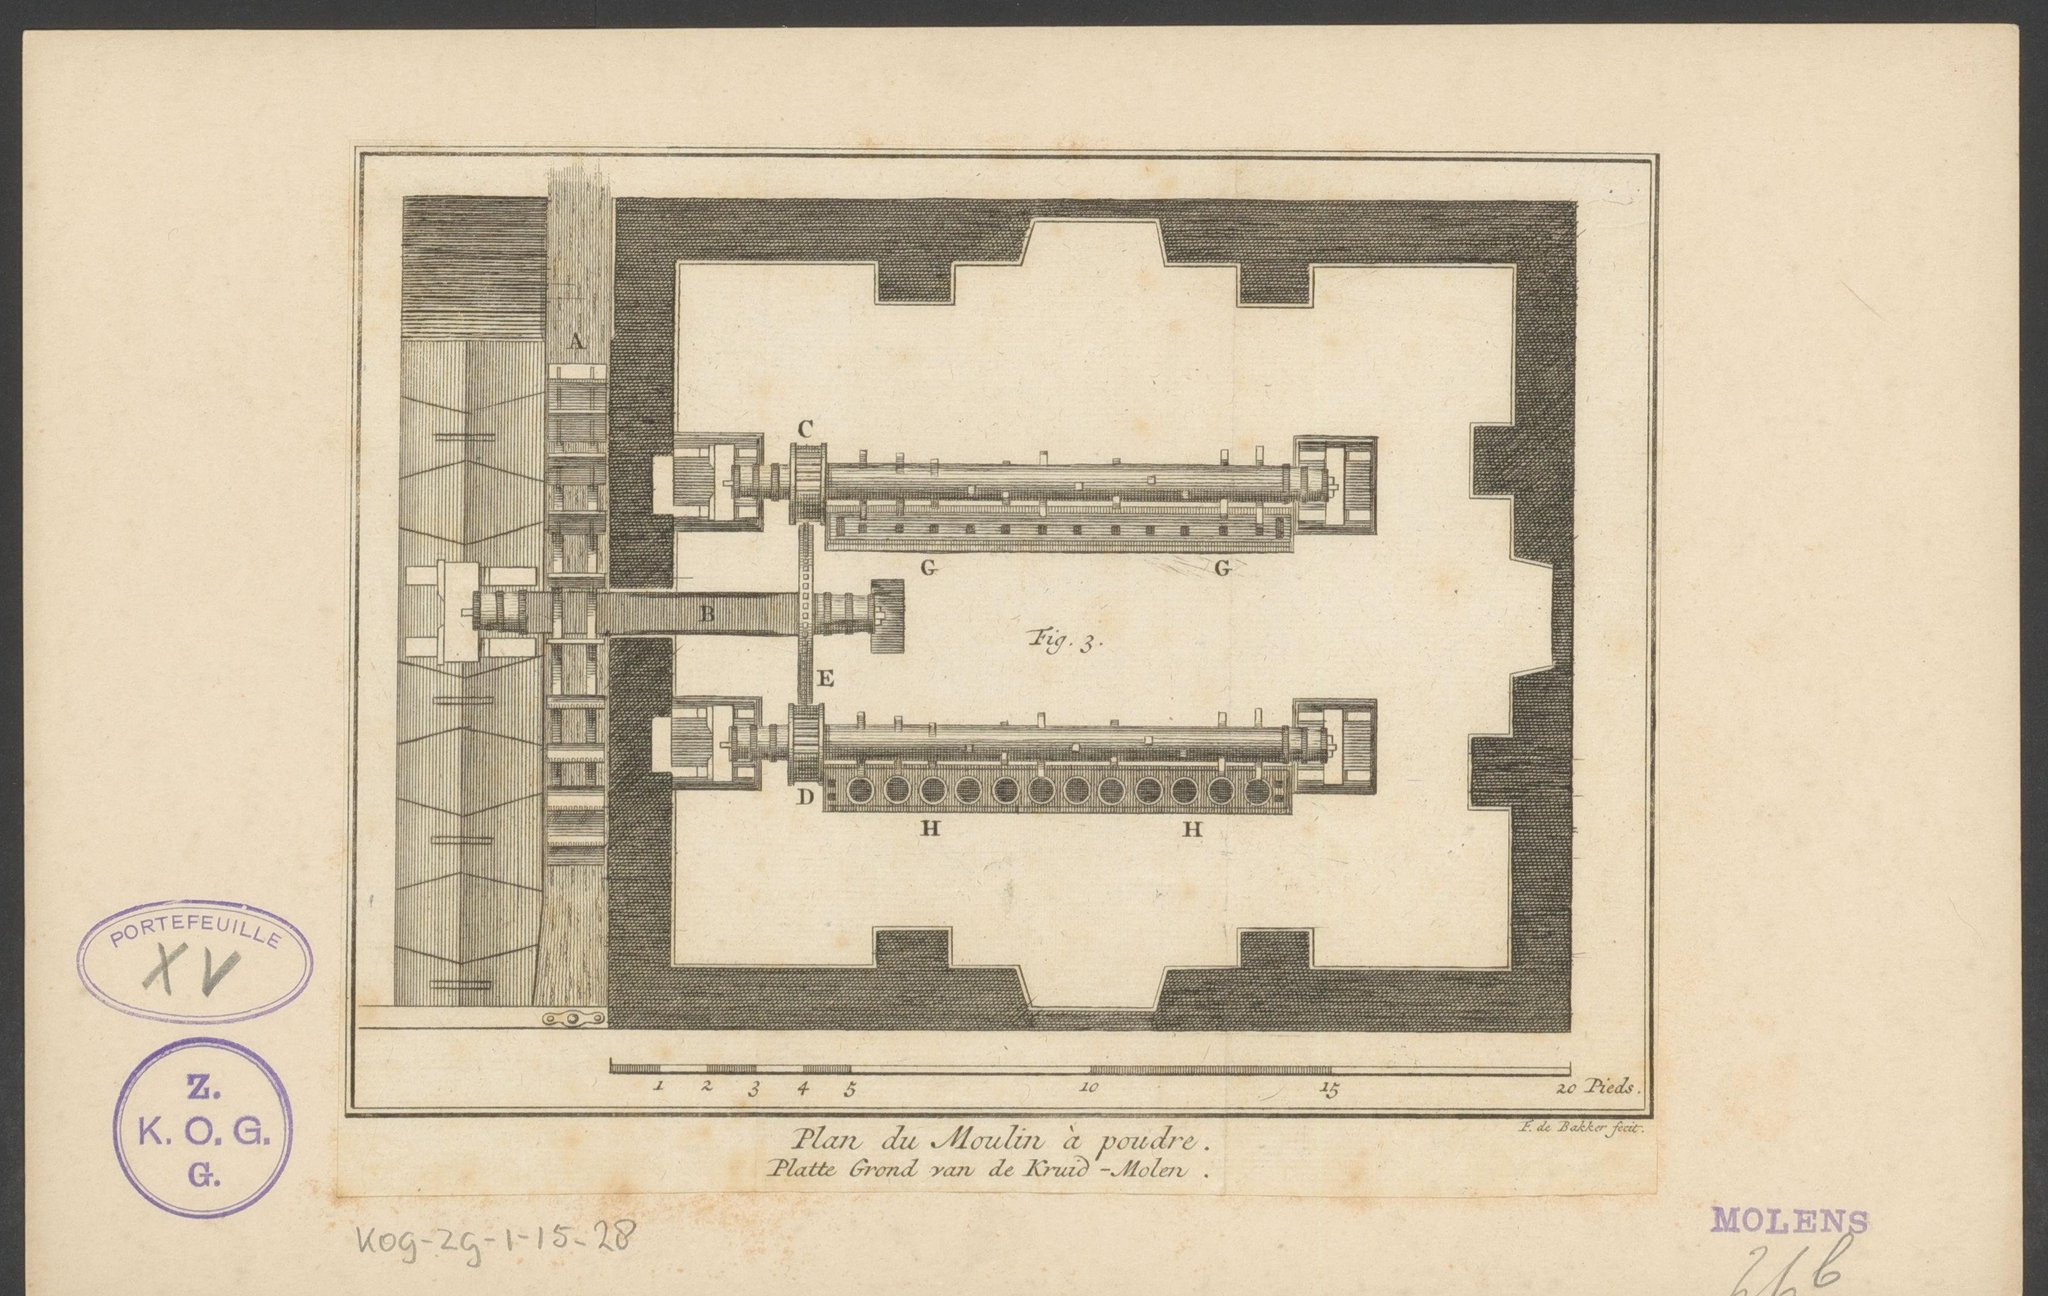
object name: print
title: Plattegrond van een kruidmolen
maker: frans de bakker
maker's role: print maker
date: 1748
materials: paper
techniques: engraving, etching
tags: grinding, milling (industrial processes)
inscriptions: stamp, stamp, collector's mark: Lugt 1641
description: Prent mogelijk uit: Noël-Antoine Pluche. Schouwtoneel der natuur, of Samenspraaken over de Bysonderheden der natuurlyke histori (...). [Vertaald uit het Frans door] Pieter le Clercq. 14 dln. Amsterdam: Salomon Schouten, 1737-1749, dl. 10, na p. 212.